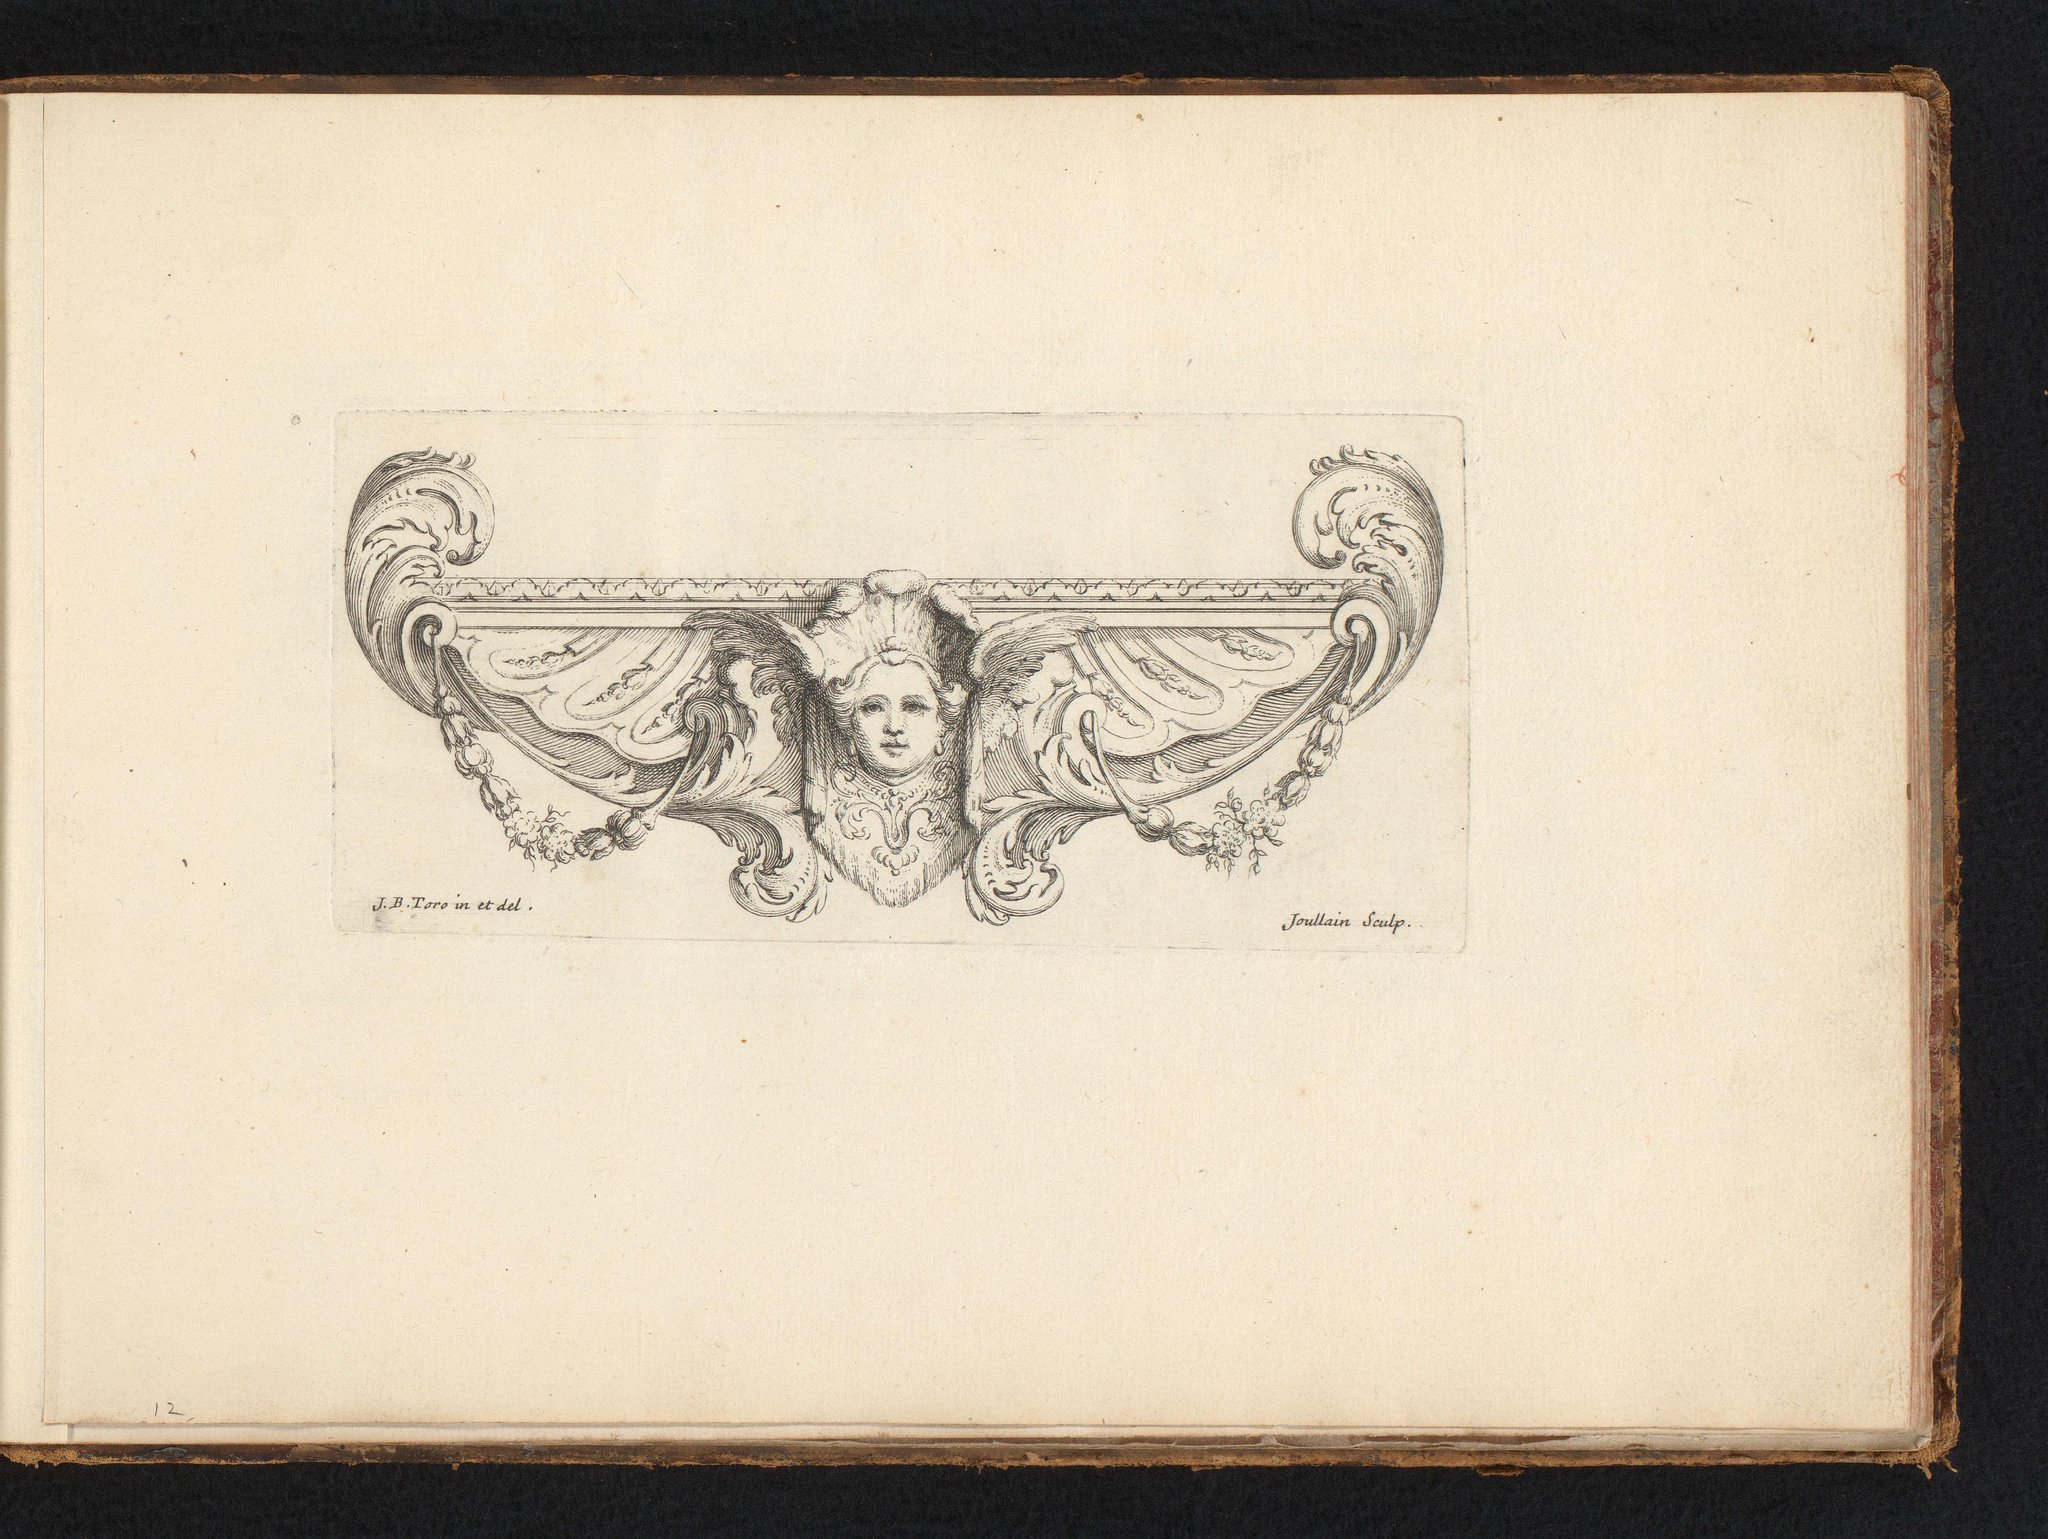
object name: album leaf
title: Nouveau Livre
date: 1682-1731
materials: paper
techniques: etching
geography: paris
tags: mask, mascaron ~ ornament, ornament ~ festoon, garland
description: Prent maakt deel uit van een serie van zes prenten.